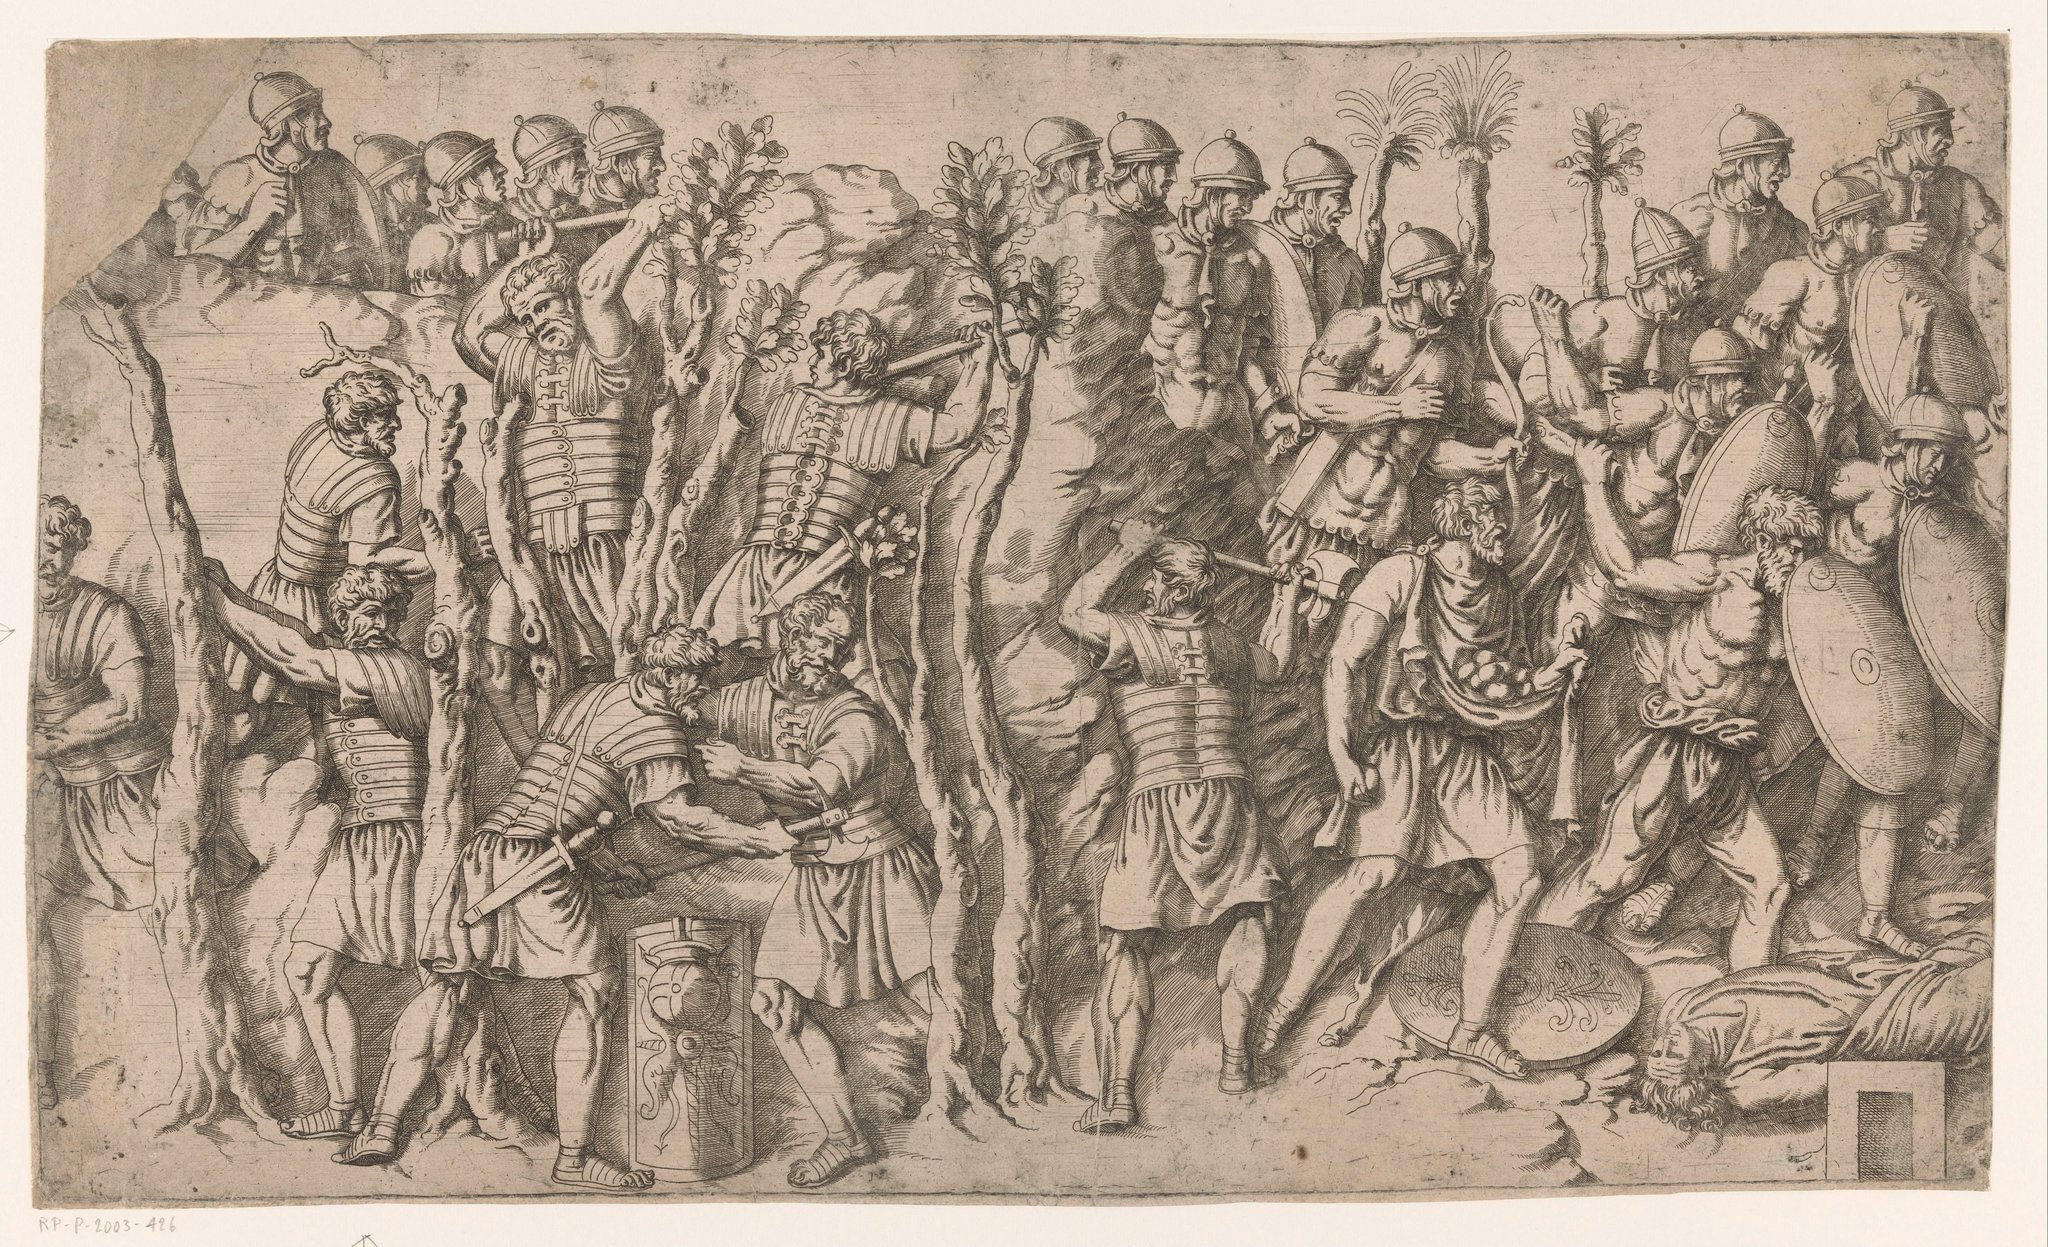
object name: print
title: Scène uit de Dacische Oorlogen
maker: antonio fantuzzi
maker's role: painter, print maker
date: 1537-1550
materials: paper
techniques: etching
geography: fontainebleau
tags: (story of) the emperor trajan, triumphal column with helical friezes, piece of sculpture, reproduction of a piece of sculpture, war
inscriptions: collector's mark: Lugt 2228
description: Deze prent maakt deel uit van een fries bestaande uit een onbekend aantal prenten met voorstellingen naar het bas-reliëf op de Zuil van Trajanus te Rome. De voorstellingen op de prenten in de collectie Rijksmuseum sluiten niet op elkaar aan.